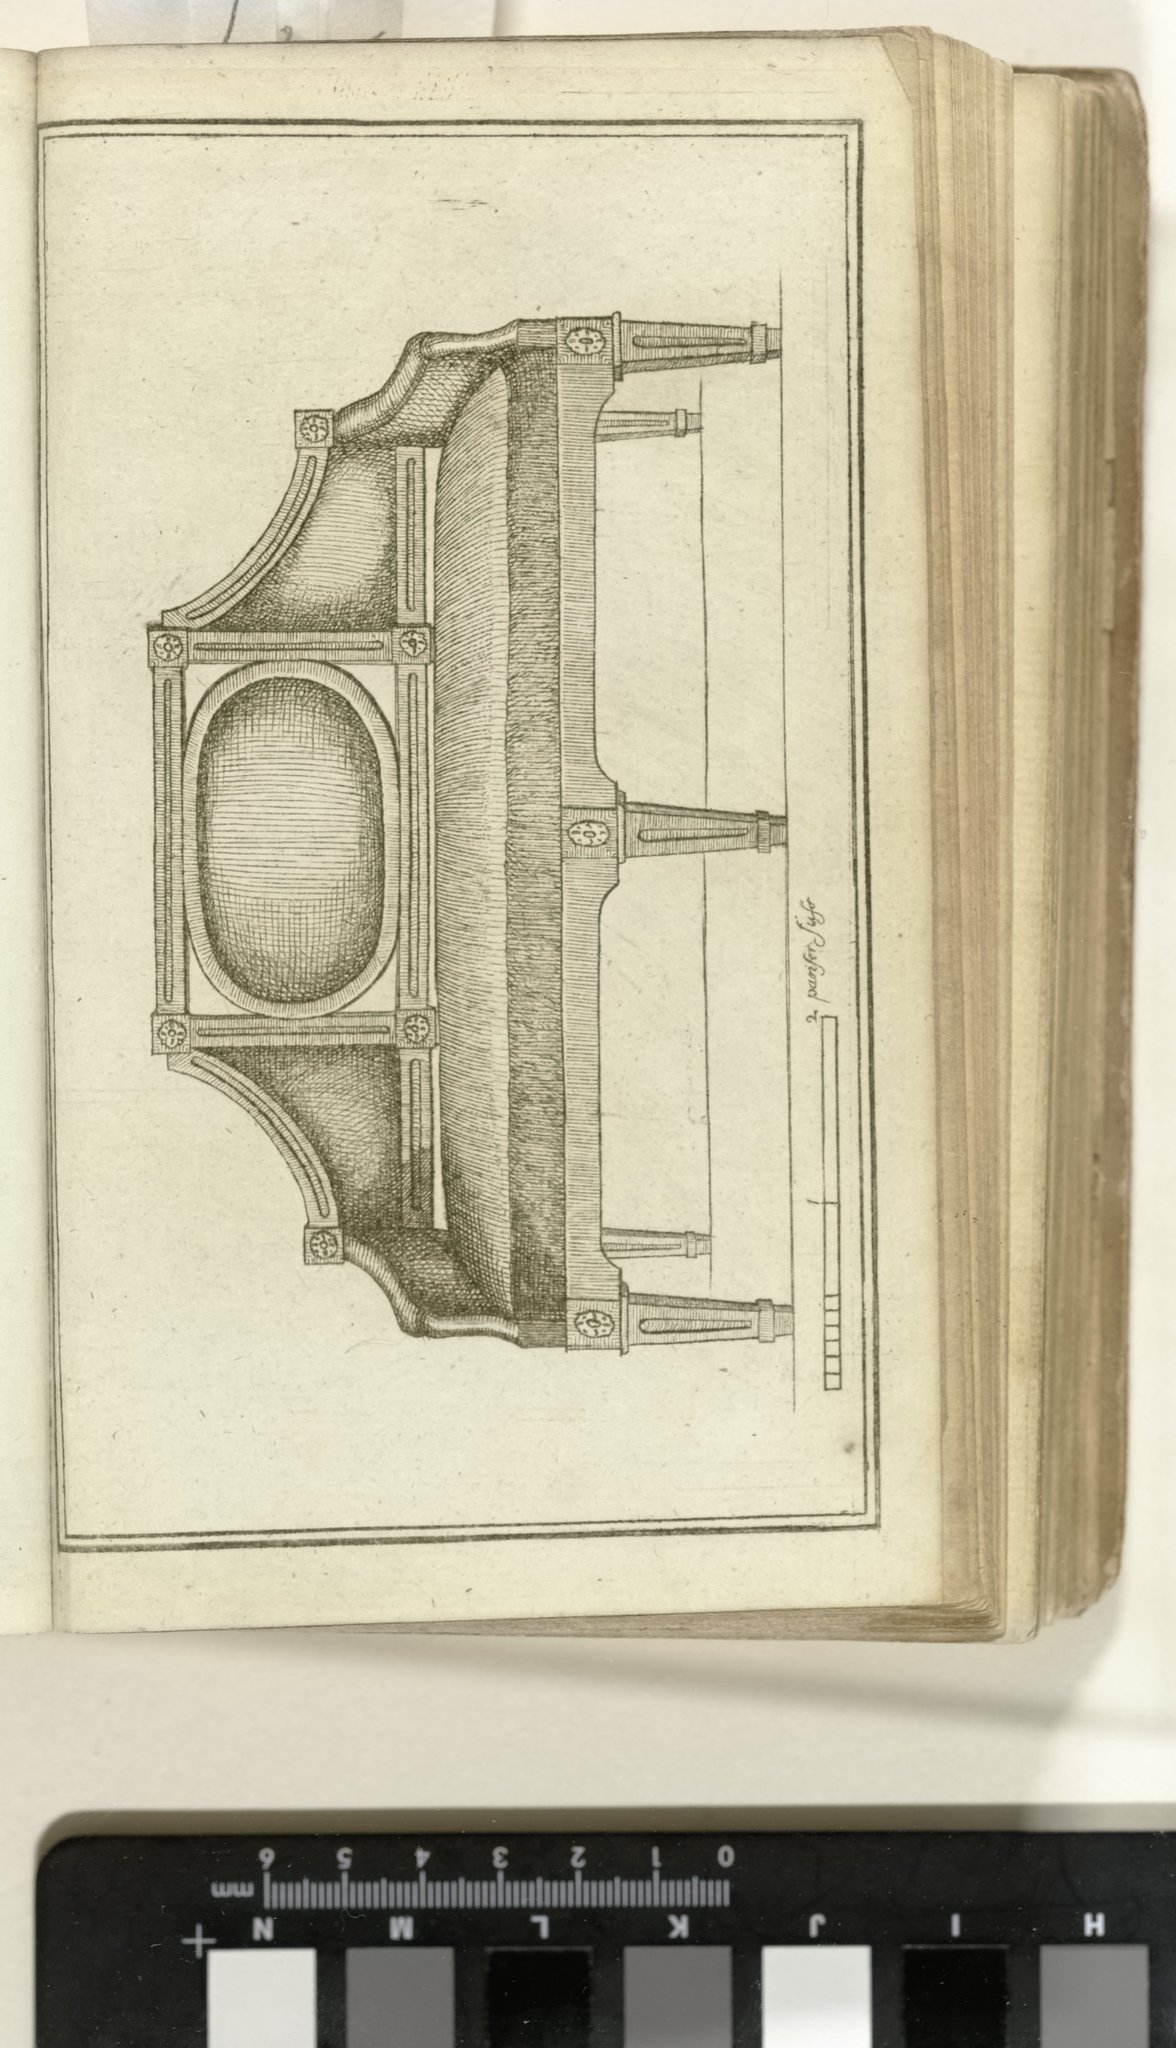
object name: fashion print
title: Journal des Luxus und der Moden 1786, Band I, T. 7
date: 1786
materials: paper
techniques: etching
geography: weimar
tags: fashion plates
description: Prent uit het modetijdschrift Journal des Luxus und der Moden, uitgegeven door Friedrich Justin Bertuch en Georg Melchior Kraus, Weimar, 1786-1826.